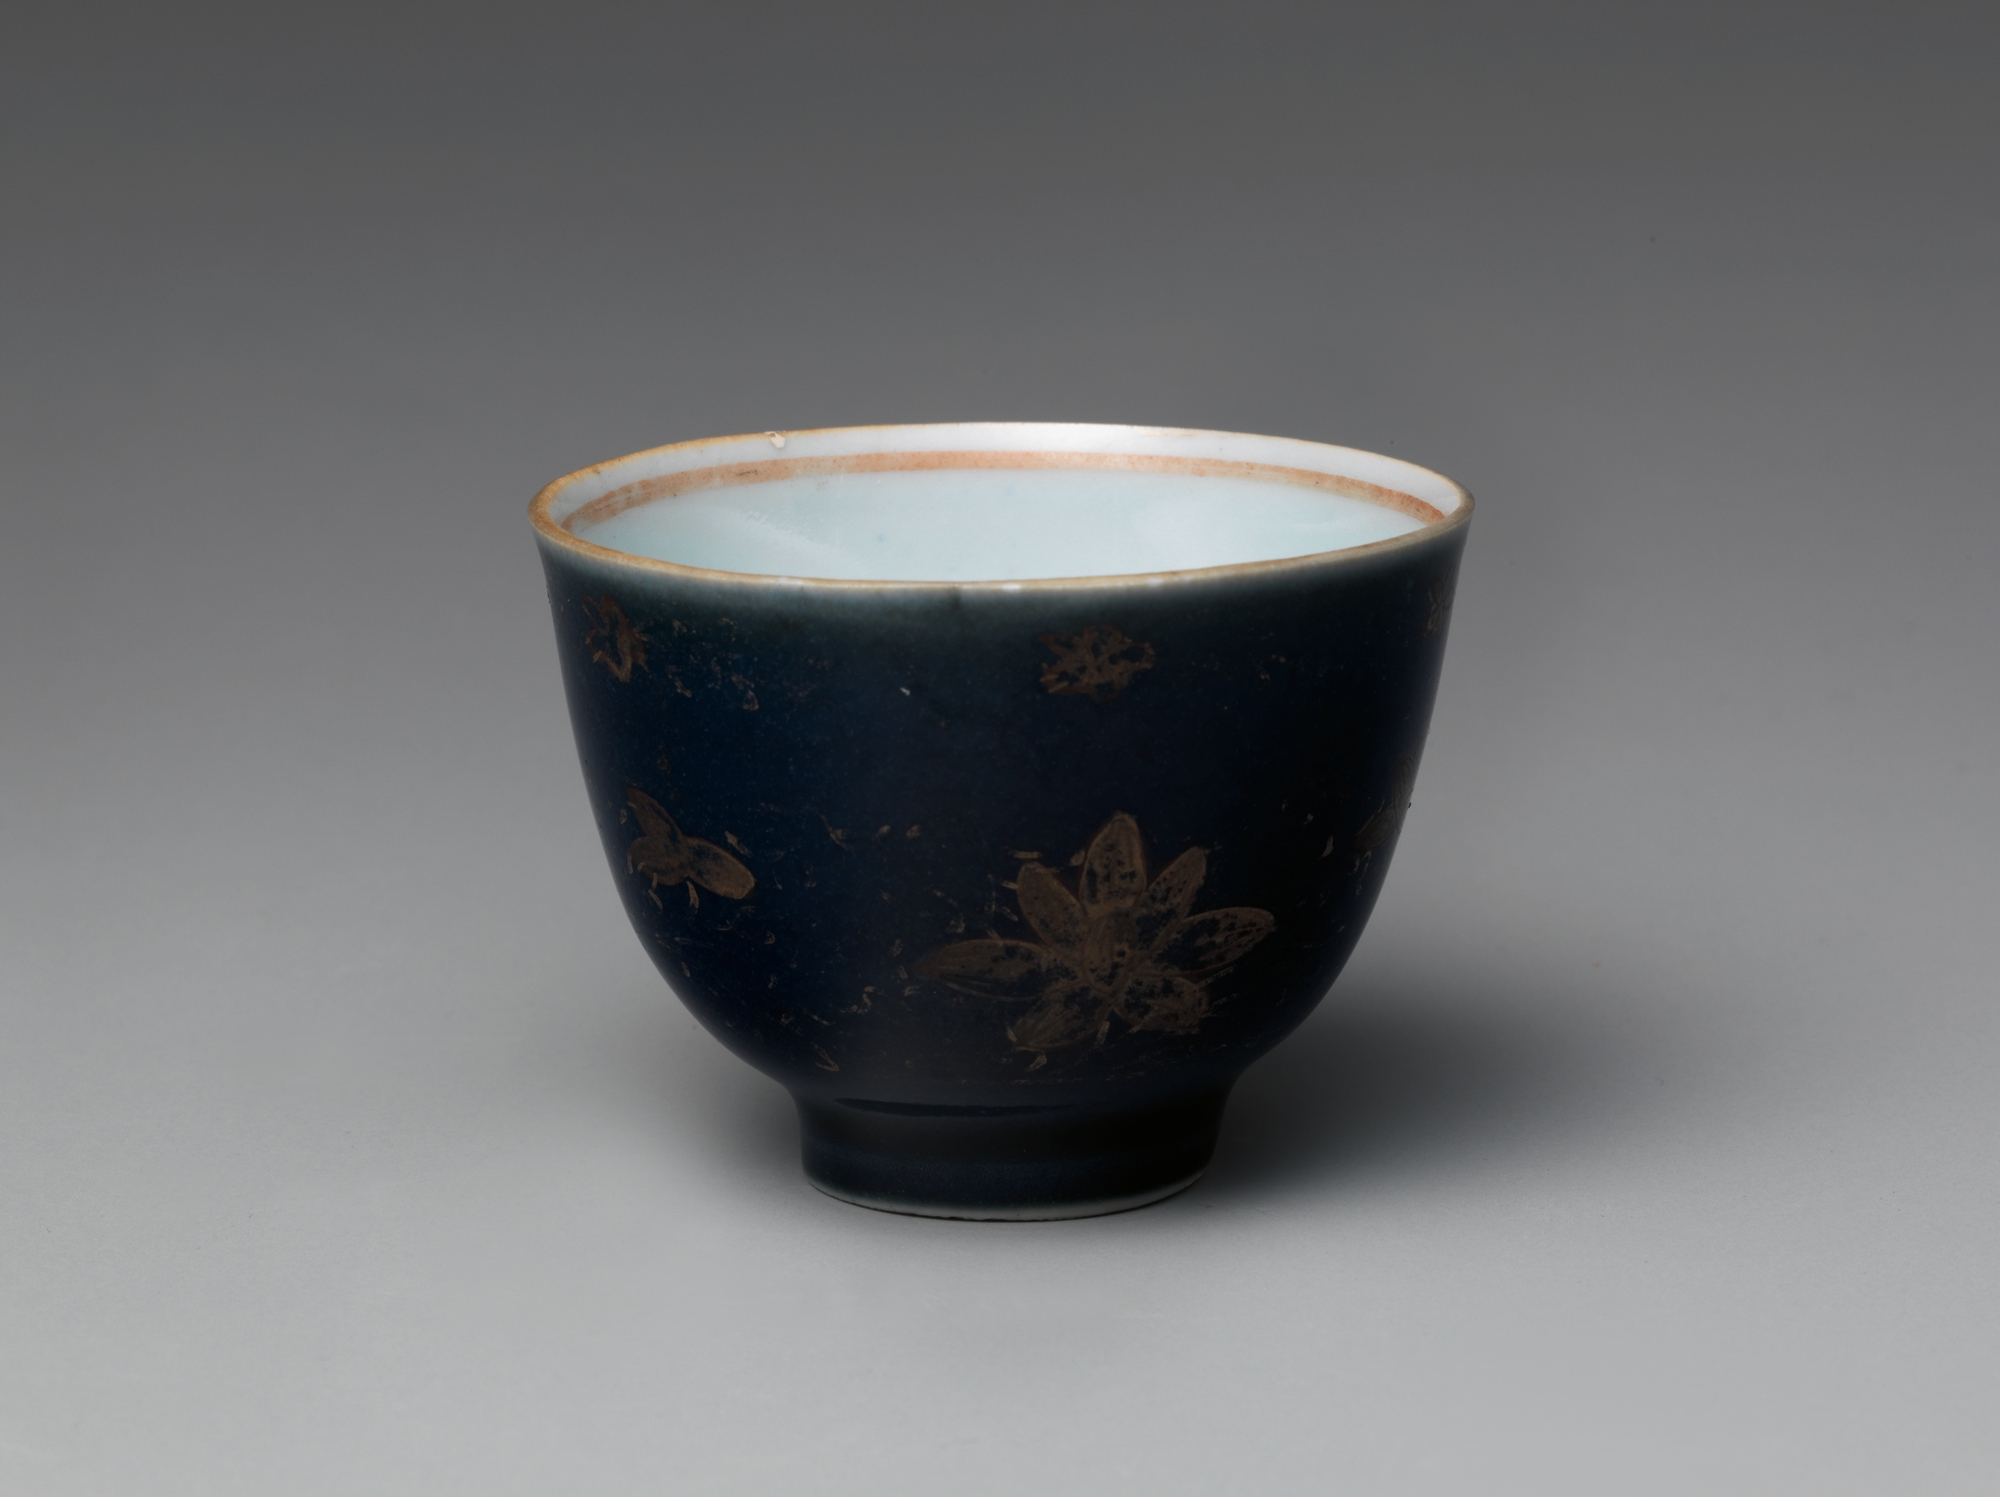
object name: cup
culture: chinese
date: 1736-1795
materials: porcelain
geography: china